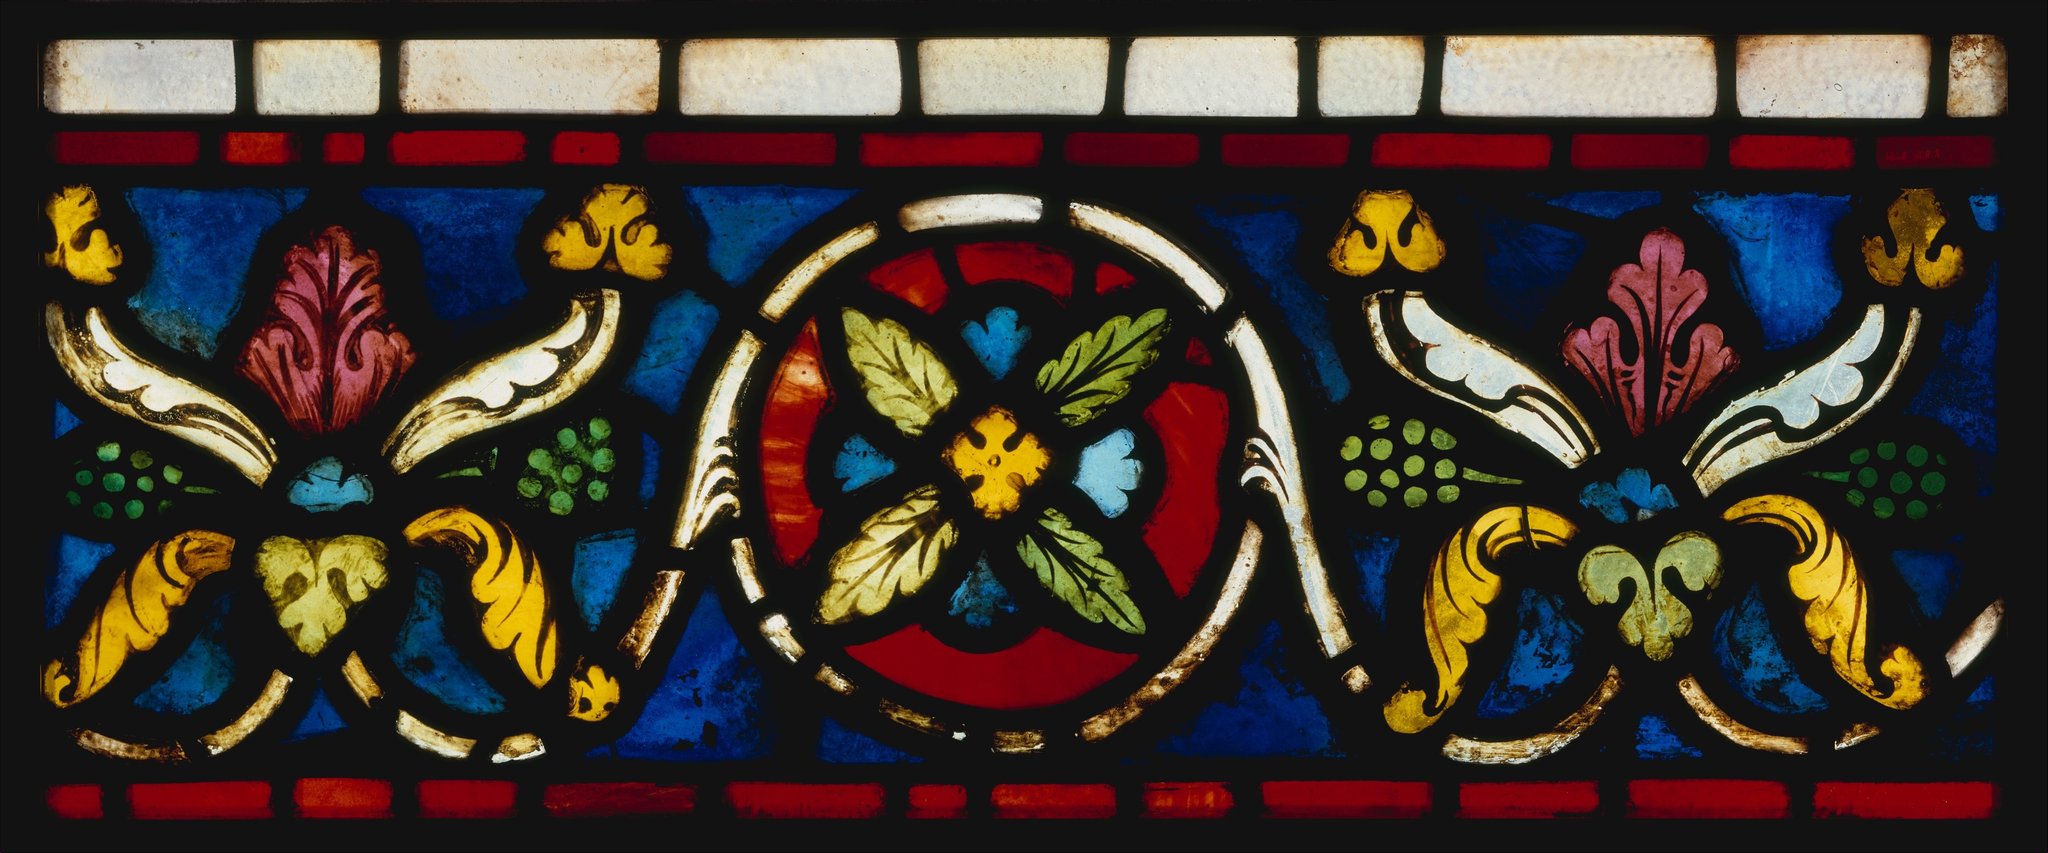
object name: border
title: Fragment of a Border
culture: french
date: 1185-1205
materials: glass, metal, paint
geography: braine or reims (?)